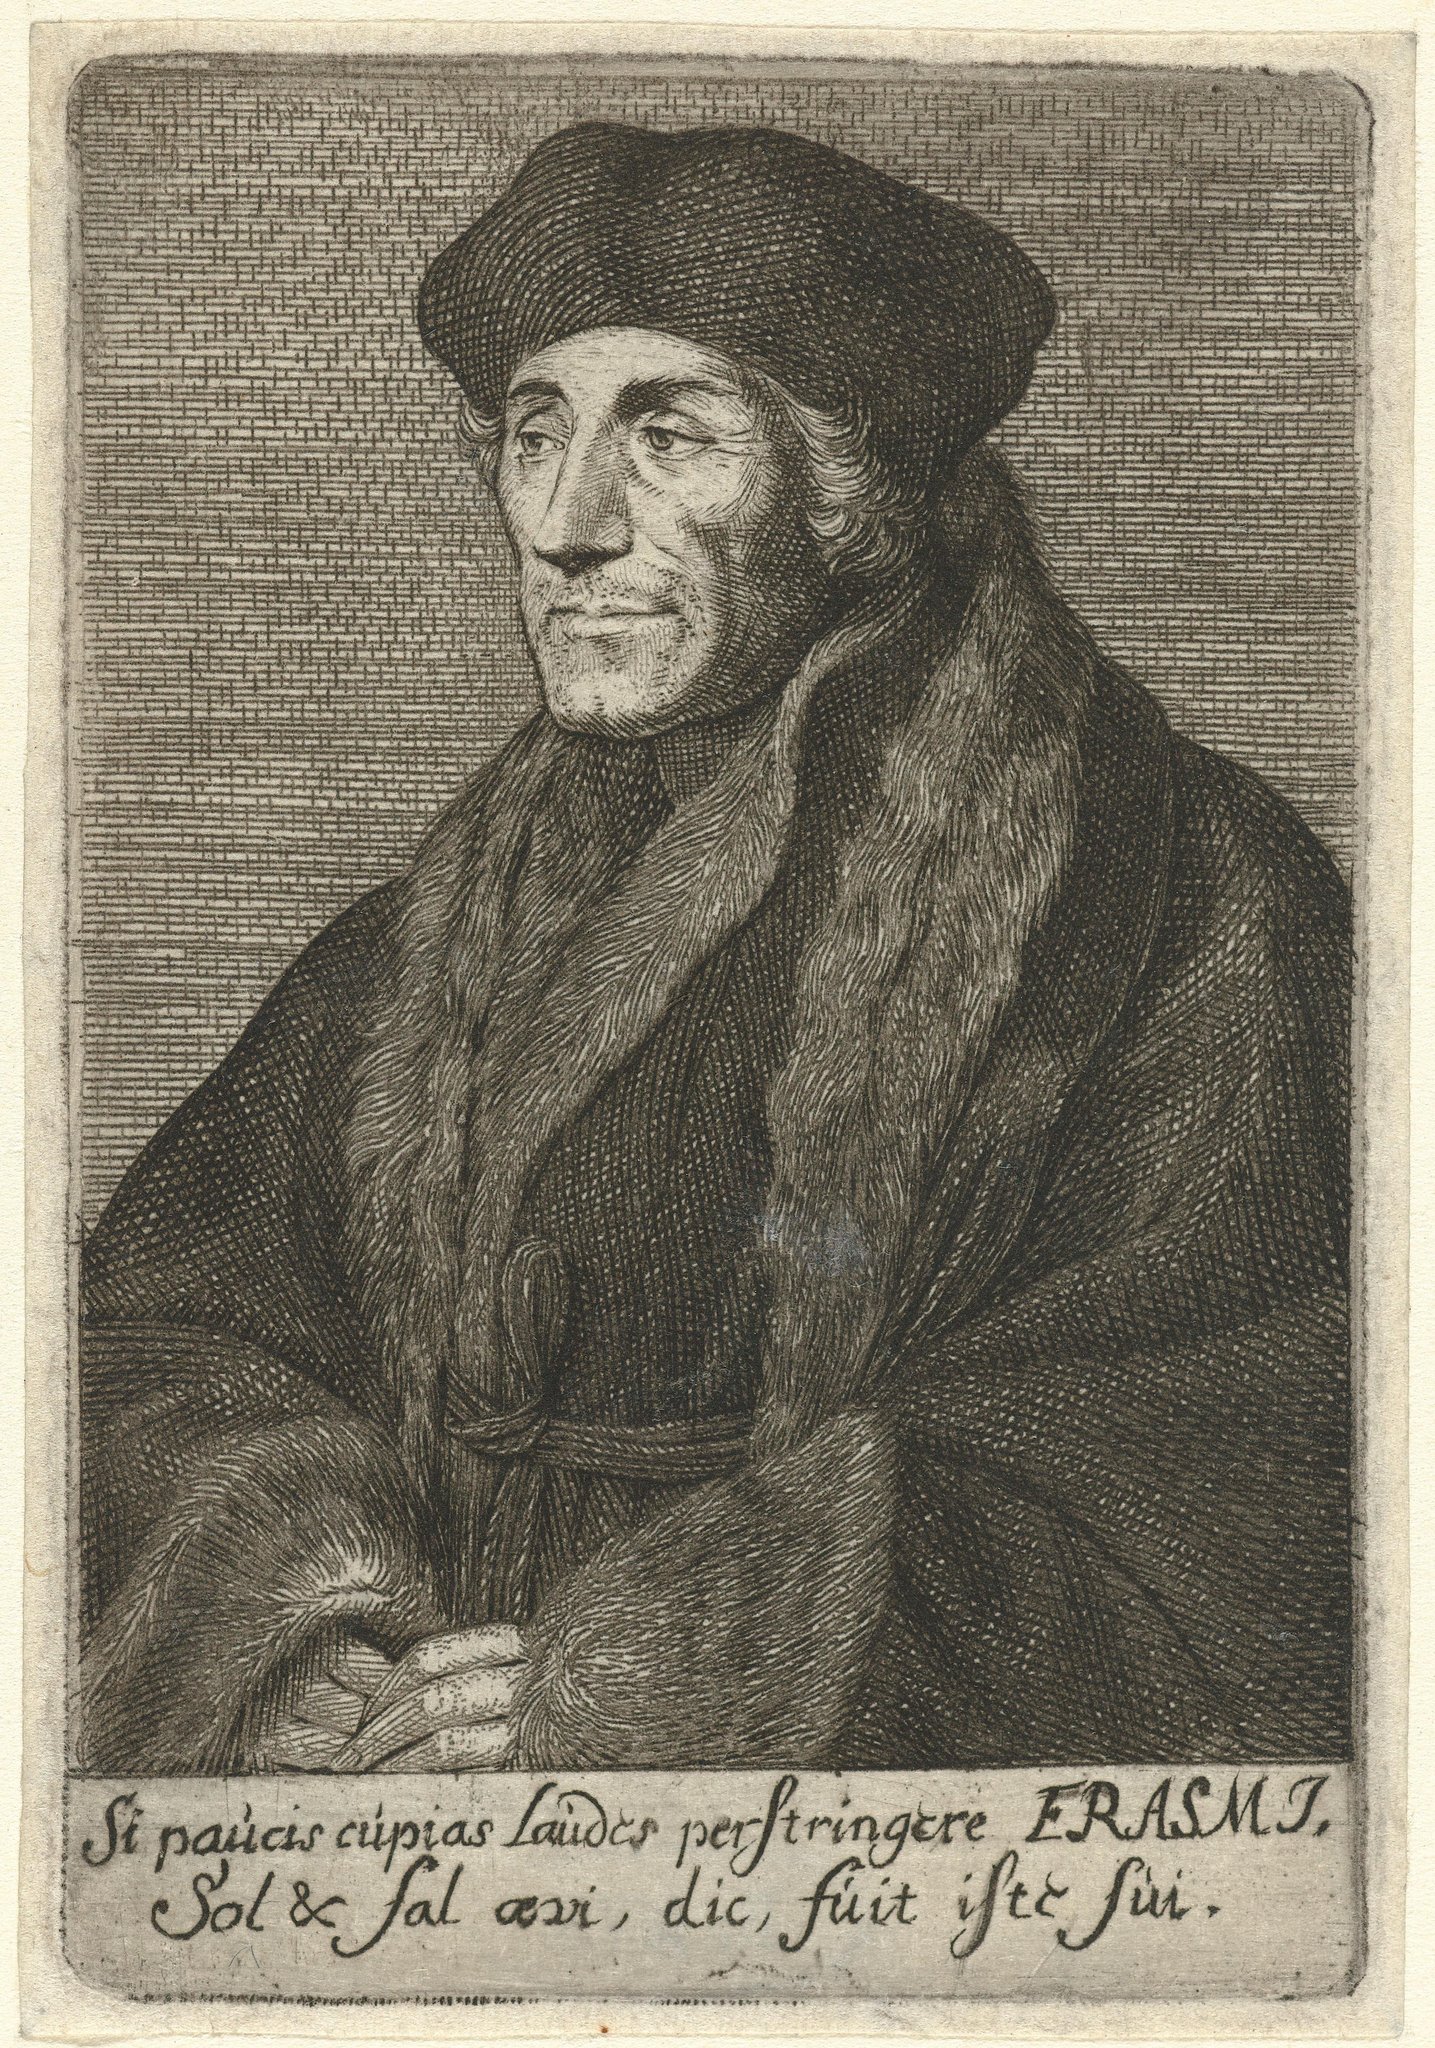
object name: print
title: Portret van Erasmus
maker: samuel van hoogstraten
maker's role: draughtsman, painter, print maker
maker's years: 1627-1678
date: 1648-1678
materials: paper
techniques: engraving, etching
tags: rotterdam, desiderius erasmus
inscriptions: inscription: ‘Si paucis cupias laudes perstringere ERASMI. Sol & fal oevi, dic, fuit, iste fui.’, collector's mark: Lugt 2228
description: Erasmus, ten halven lijve, met bont afgezette mantel. Onder het portret tweeregelige tekst in Latijn.